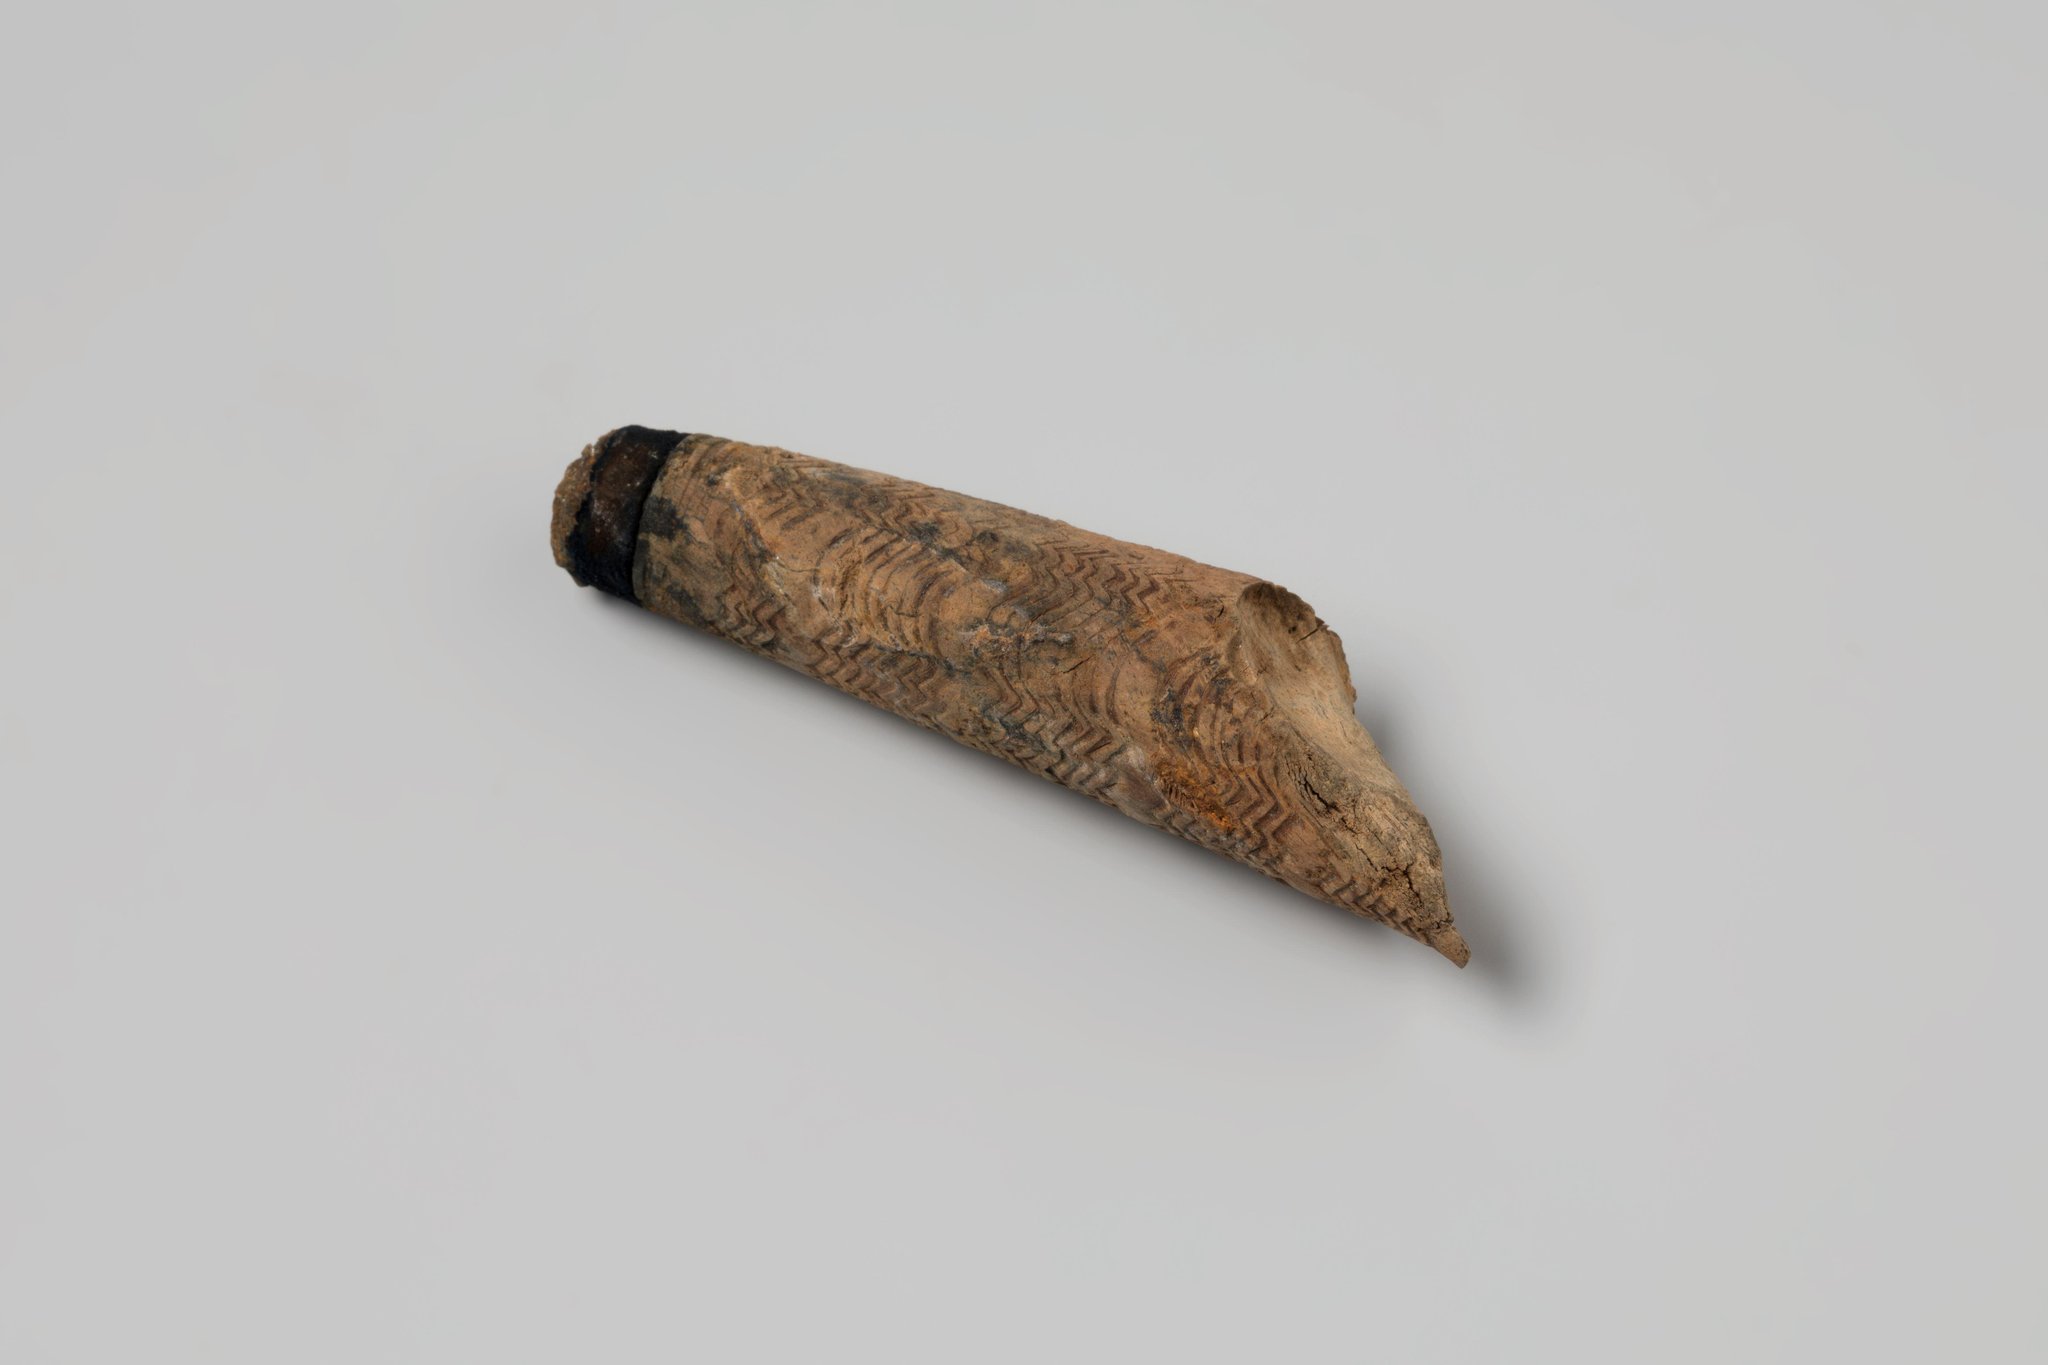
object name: knife handle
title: Messenheft uit het wrak van de Oost-Indiëvaarder Hollandia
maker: Anonymous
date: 1700-1743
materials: metal, wood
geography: netherlands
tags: verenigde oostindische compagnie, hollandia (schip), annet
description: Knife, handle, cylindrical: tapering; fragm, id. NG 1980-27H512a.